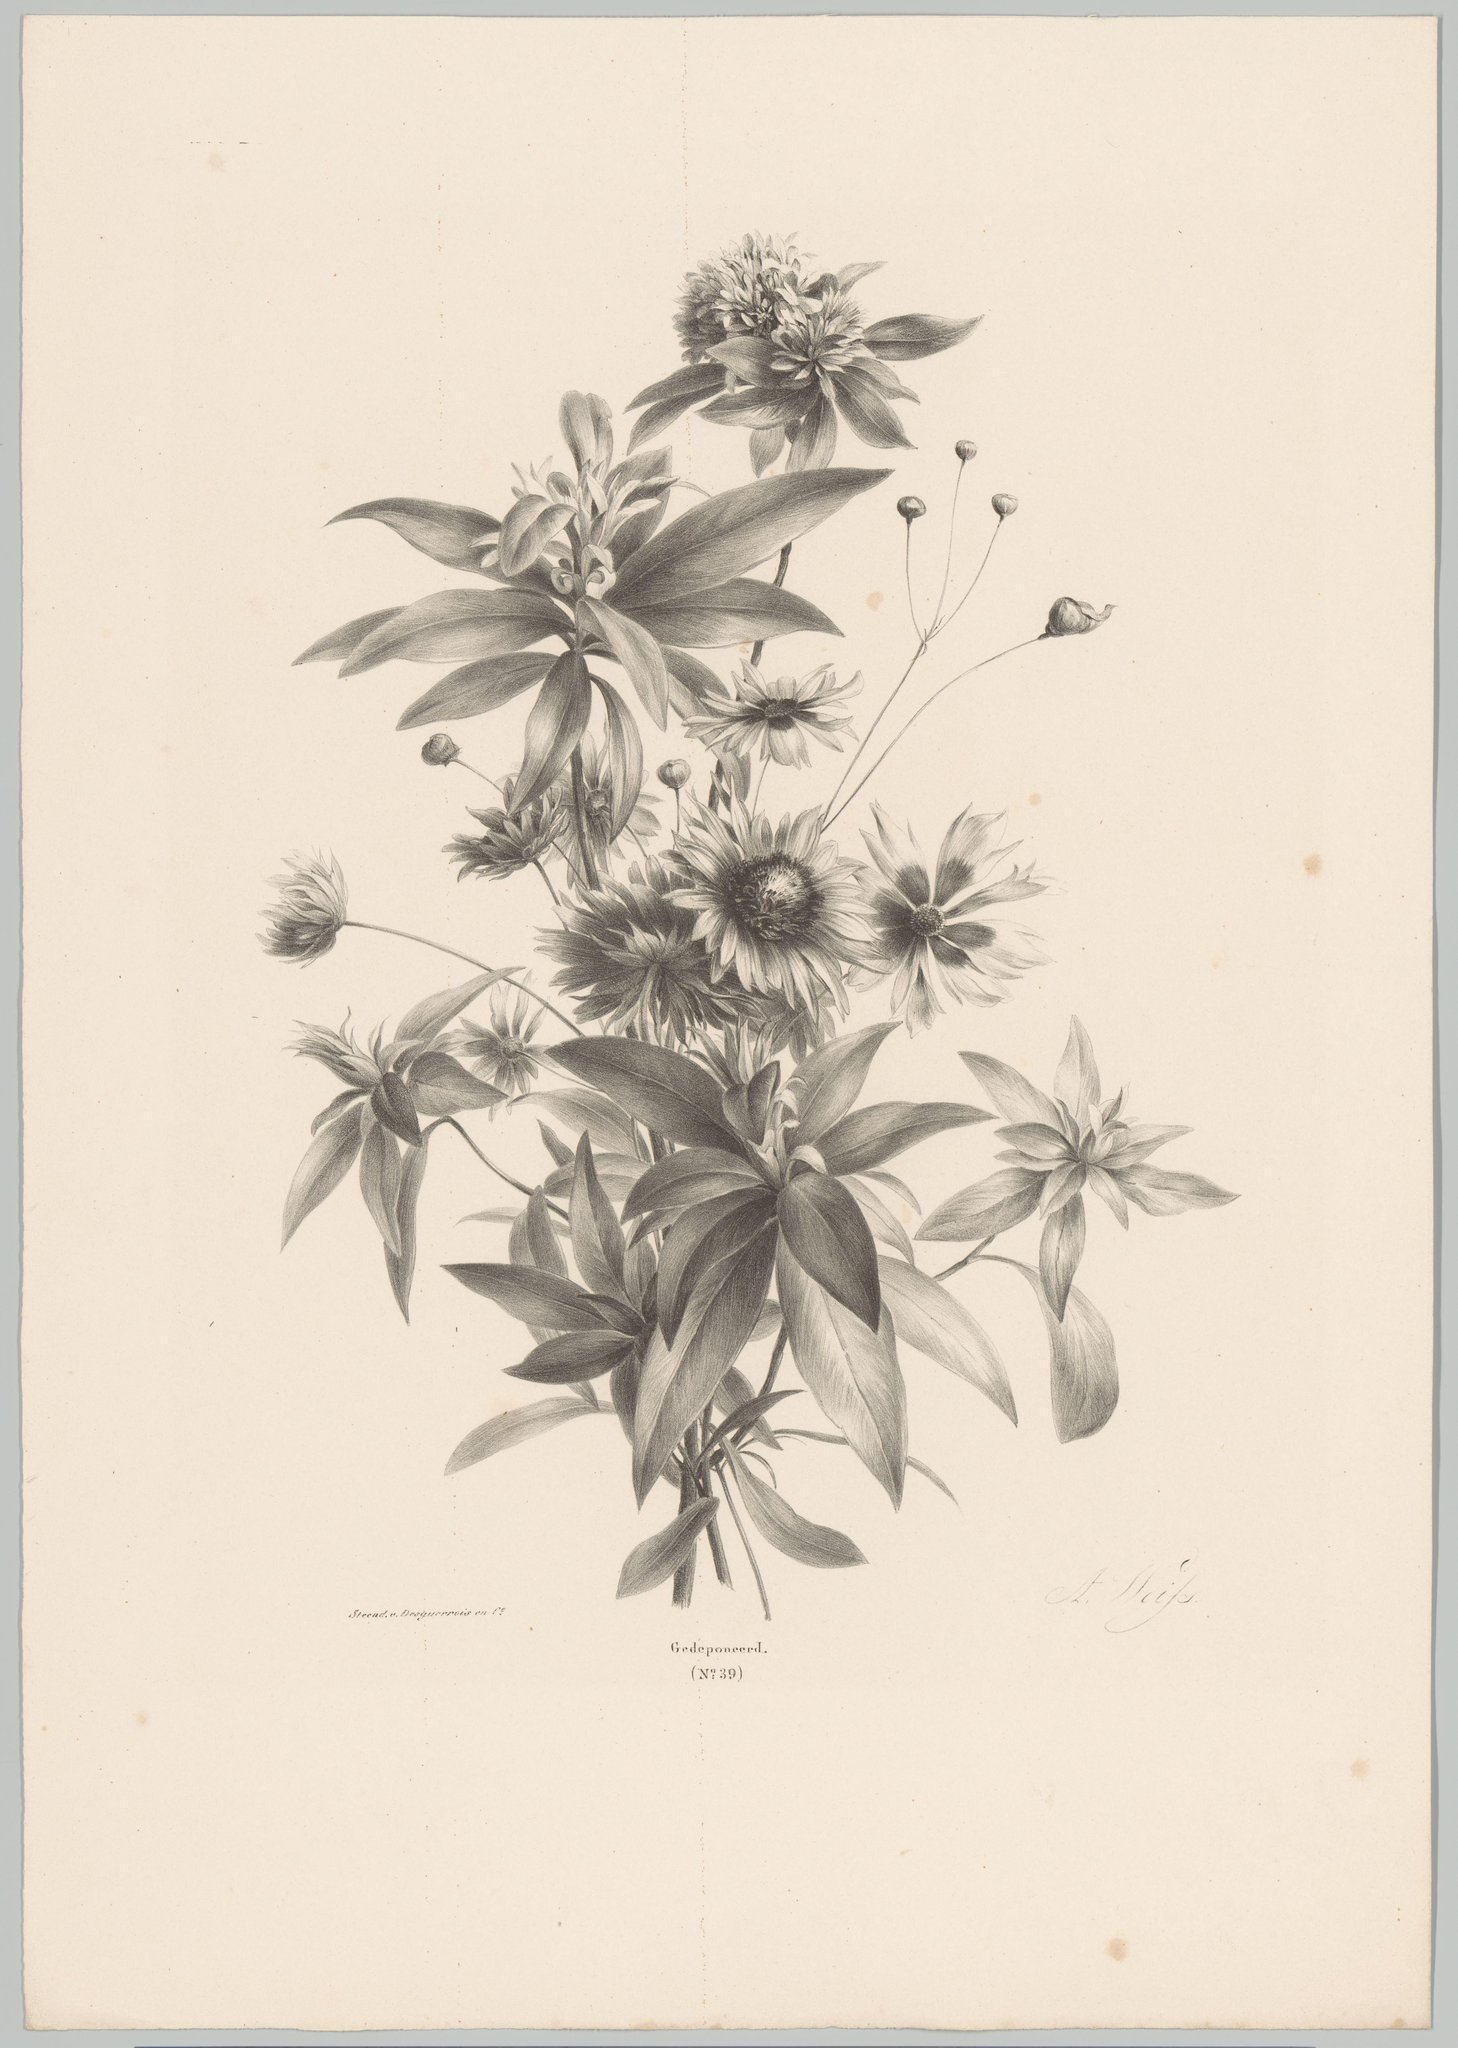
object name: print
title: Bloem en Fruit Studien (...) 10e aflevering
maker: anton weiss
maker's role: draughtsman, print maker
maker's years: 1801-1851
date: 1836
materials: paper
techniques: lithograph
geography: amsterdam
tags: flowers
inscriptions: : ‘Gedeponeerd.’, collector's mark: Lugt 2228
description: Onderdeel van een omslag met een serie van eenenveertig lithografieën van bloemen en fruit.